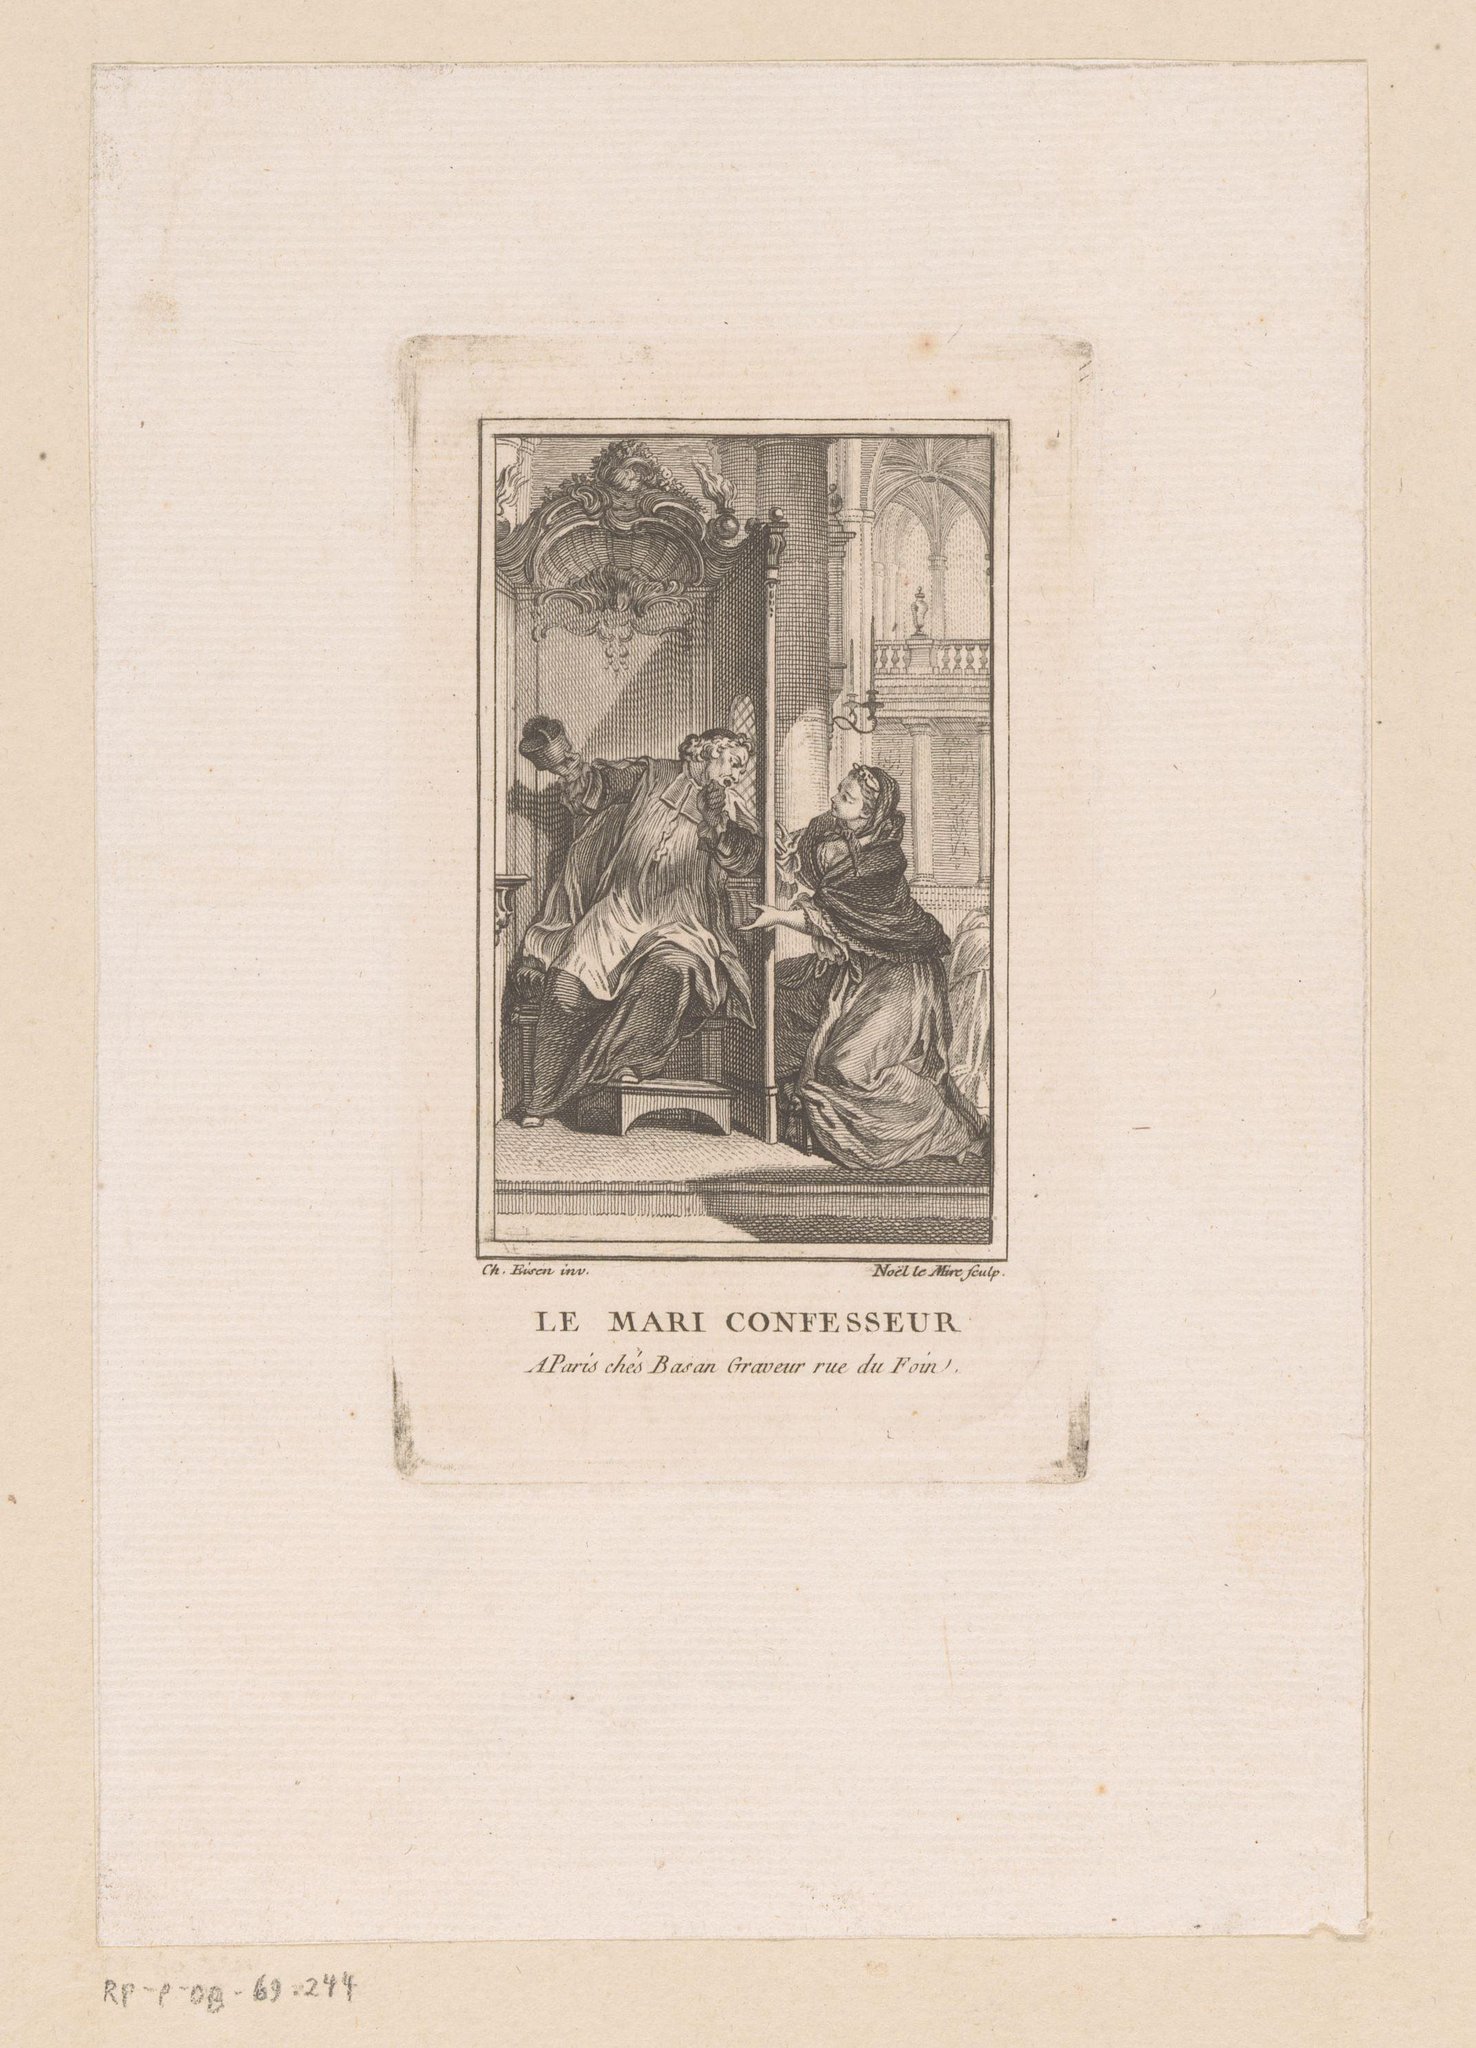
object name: print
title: Le mari confesseur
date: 1762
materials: paper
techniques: engraving, etching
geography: france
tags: interior of church, confessional ~ part of the confession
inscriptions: collector's mark: Lugt 240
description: Mogelijk prent uit: Fontaine, Jean de La. Contes et nouvelles en vers. Parijs: Basan, 1762.